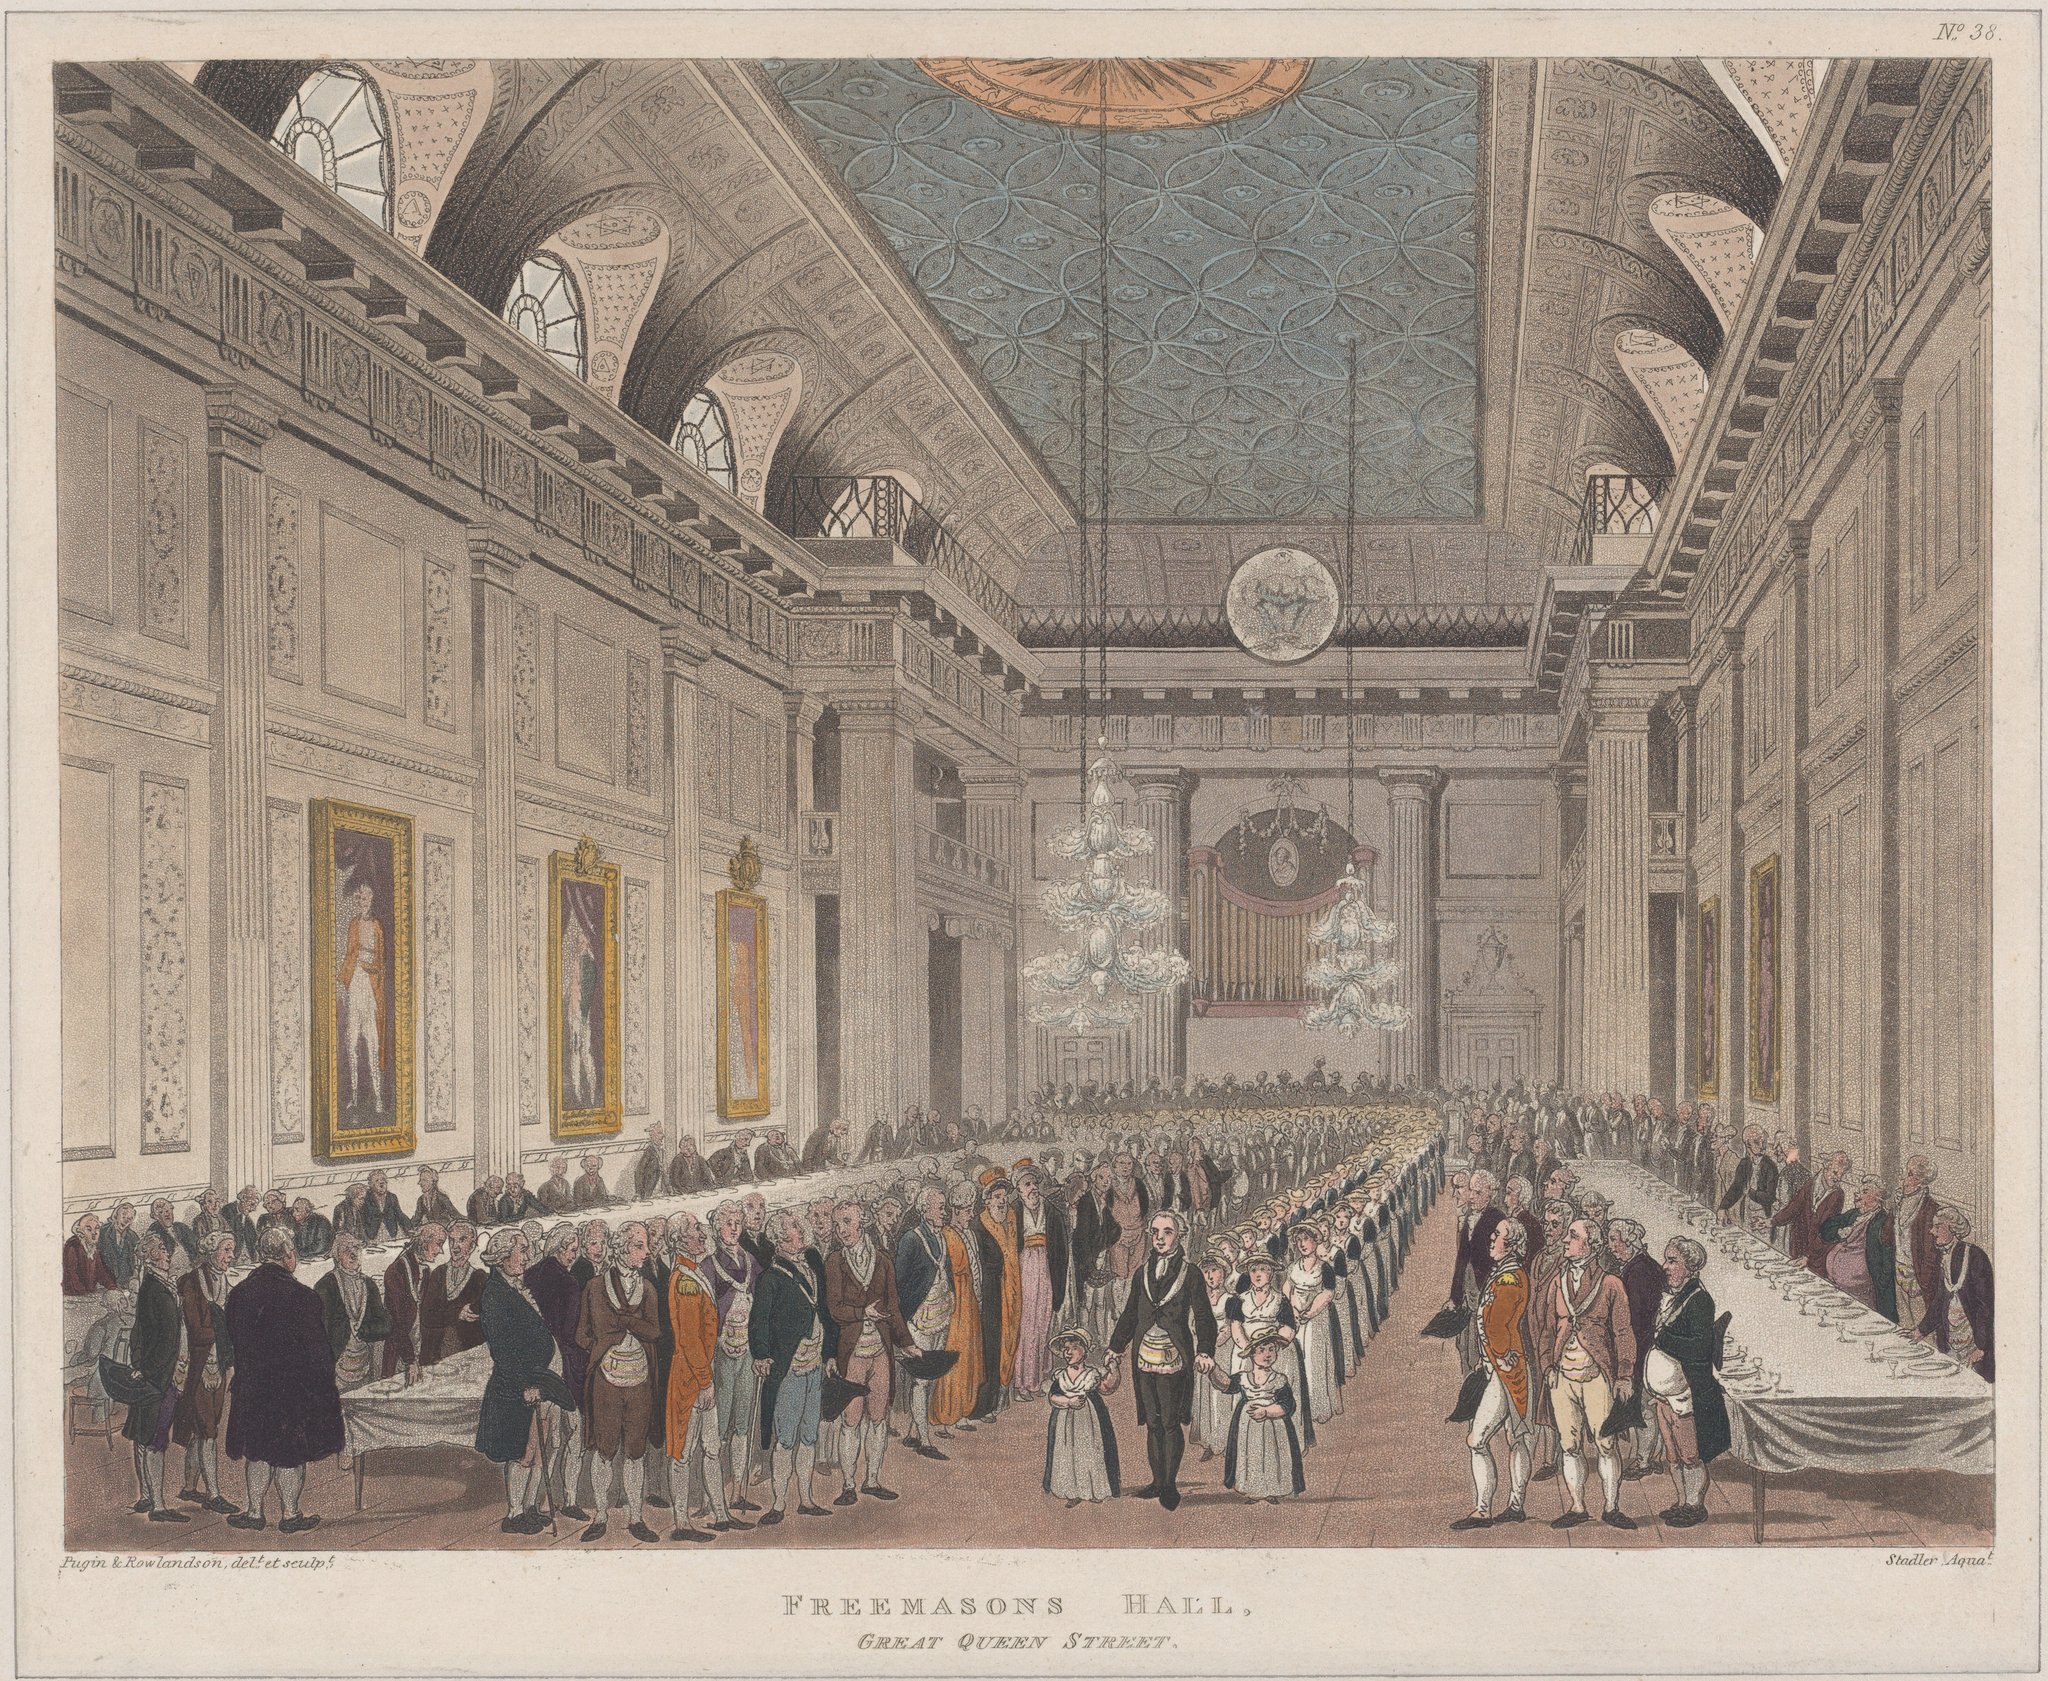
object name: print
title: Freemasons' Hall, Great Queen Street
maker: thomas rowlandson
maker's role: artist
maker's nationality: british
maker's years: 1757-1827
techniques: aquatint, etching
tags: interiors,children,men,women,dining,london